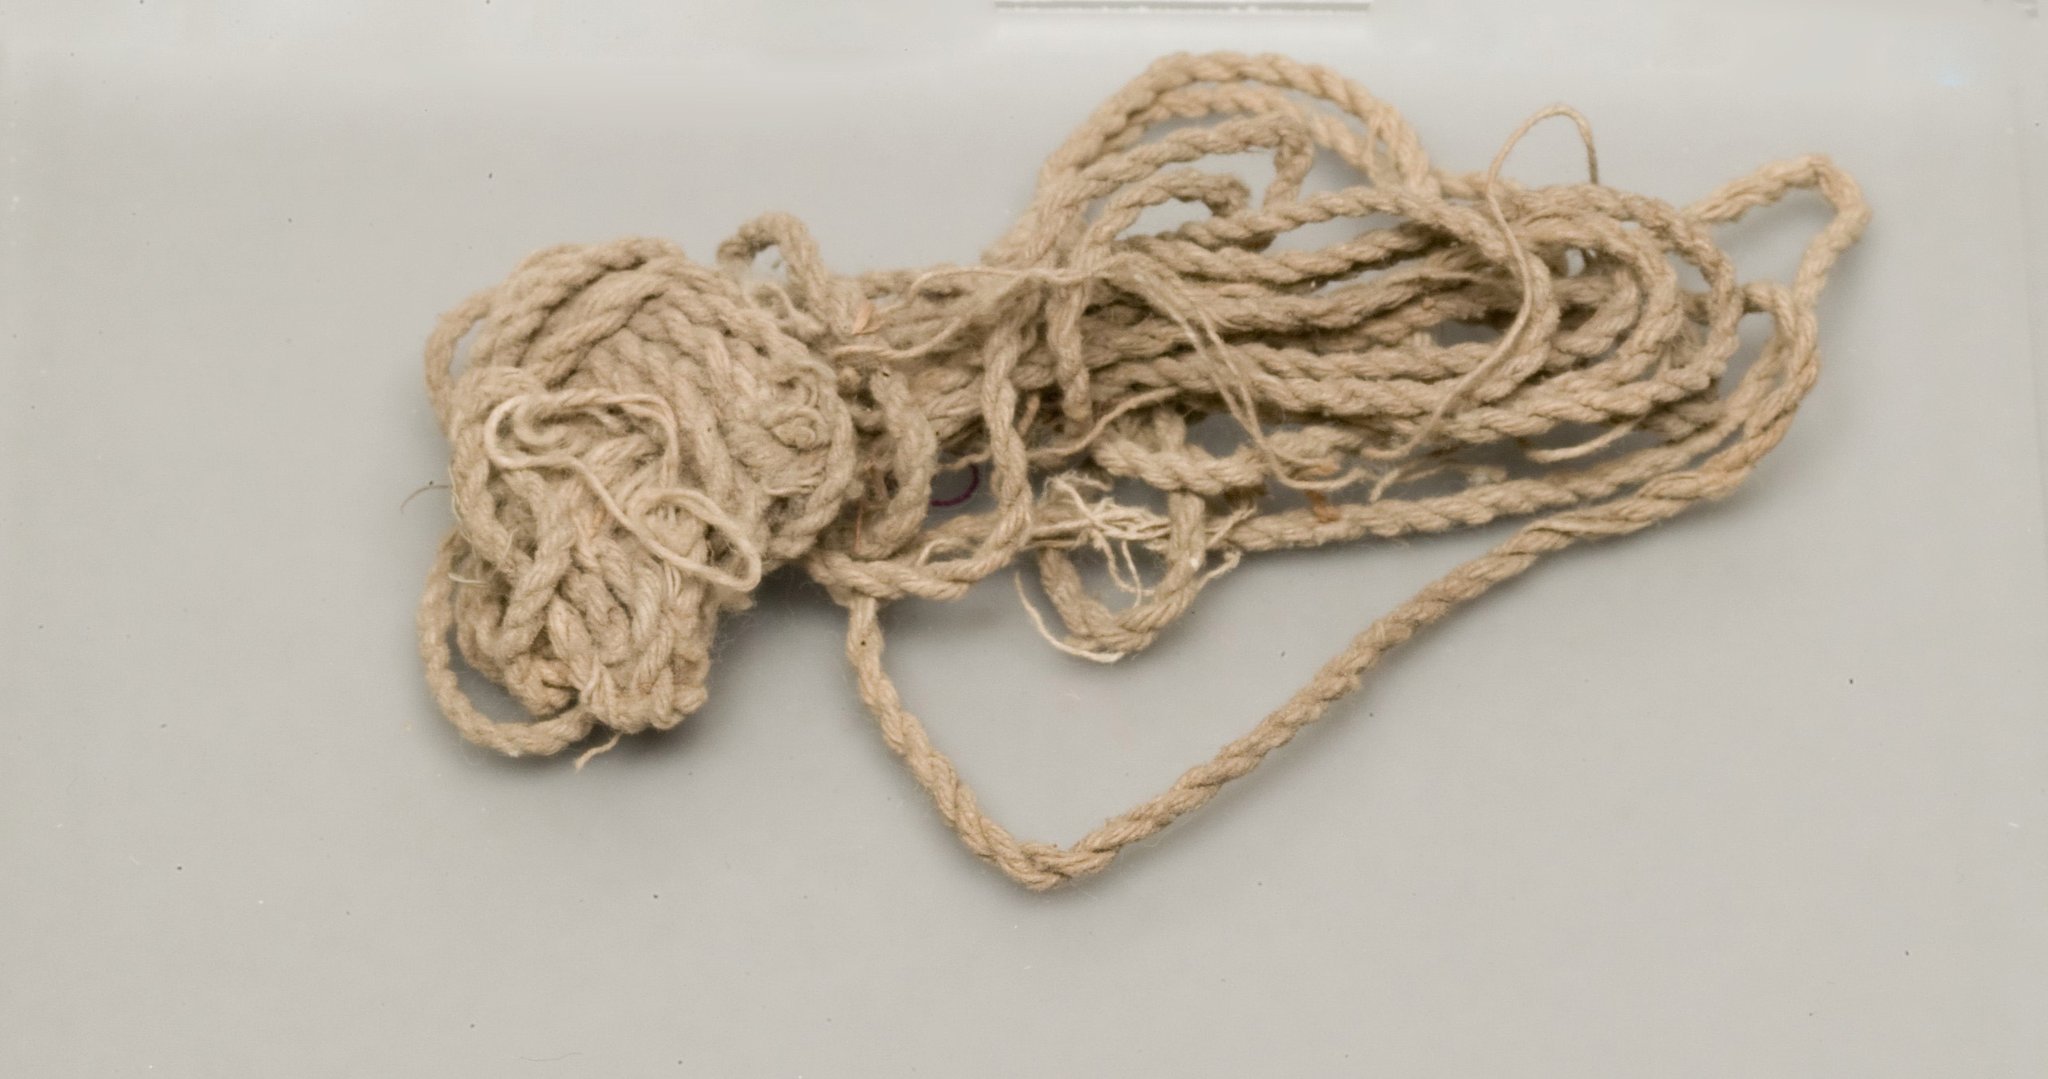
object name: rope, fishing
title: Fishing Line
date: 1295-1070 BCE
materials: cord, linen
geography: egypt